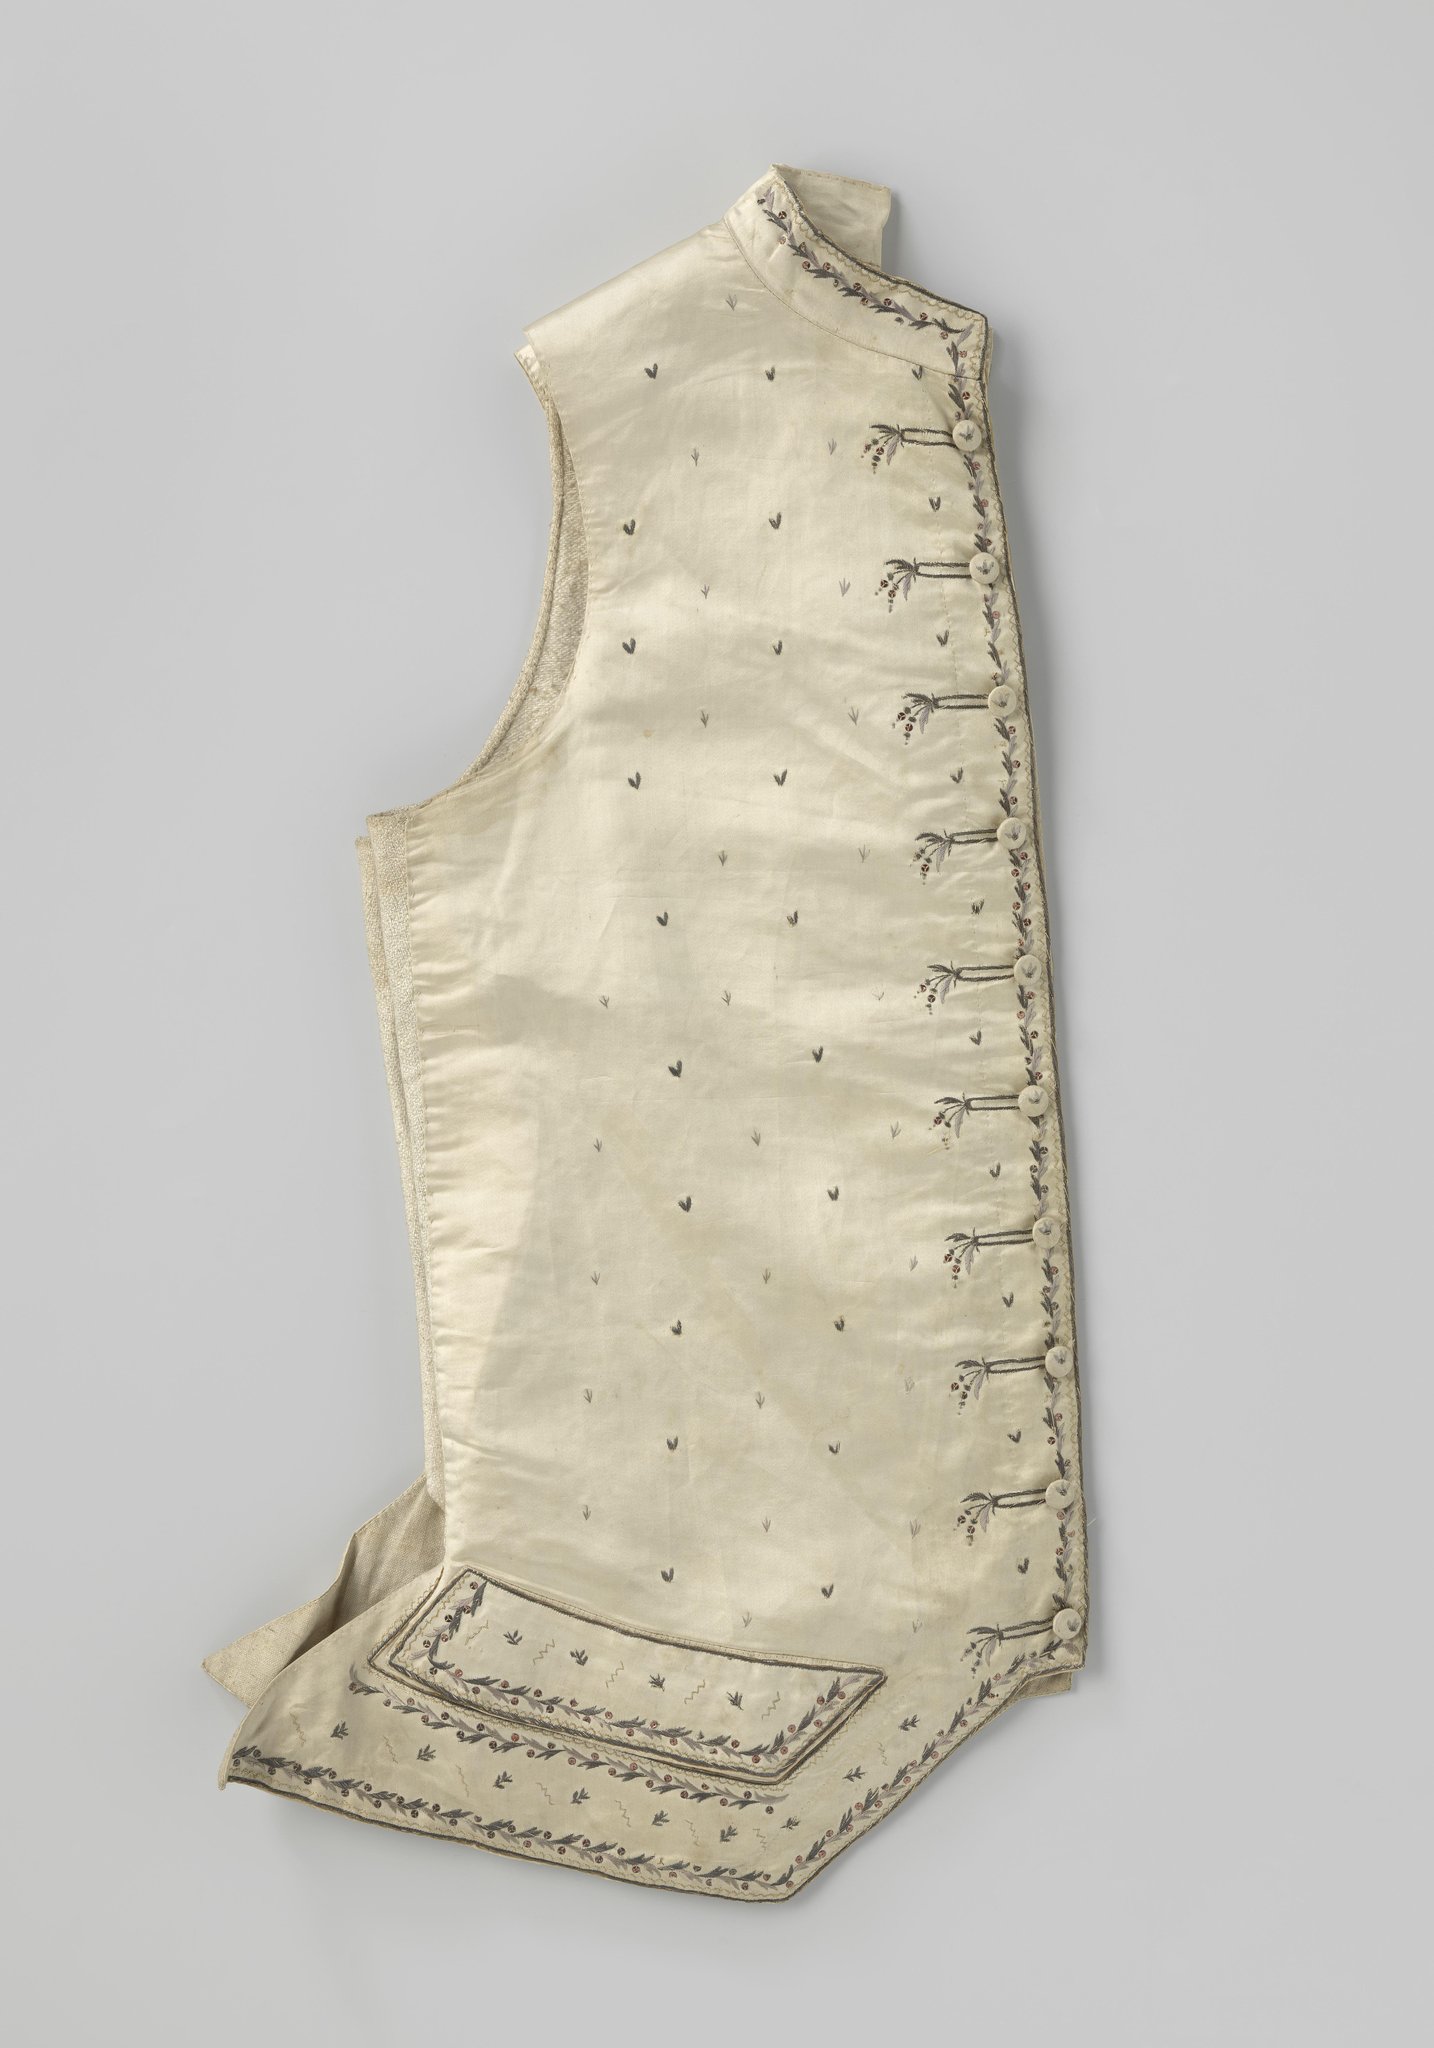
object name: vest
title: Vest van crème satijn, in zijde- en metaaldraad geborduurd met een V-vormig strooimotief en blad- en bloemranken in grijstinten en rode pailletten; smalle staande kraag.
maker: Anonymous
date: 1700-1800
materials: linen, metal thread, textile, silk, wool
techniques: embroidered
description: Vest van wit satijn met zilveren en grijs zijden borduursel en rose pailletten. Strooipatroon. De bovenste twee knoopsgaten dicht, op die plaats van binnen een geborduurd belegstuk. Smal staand kraagje.